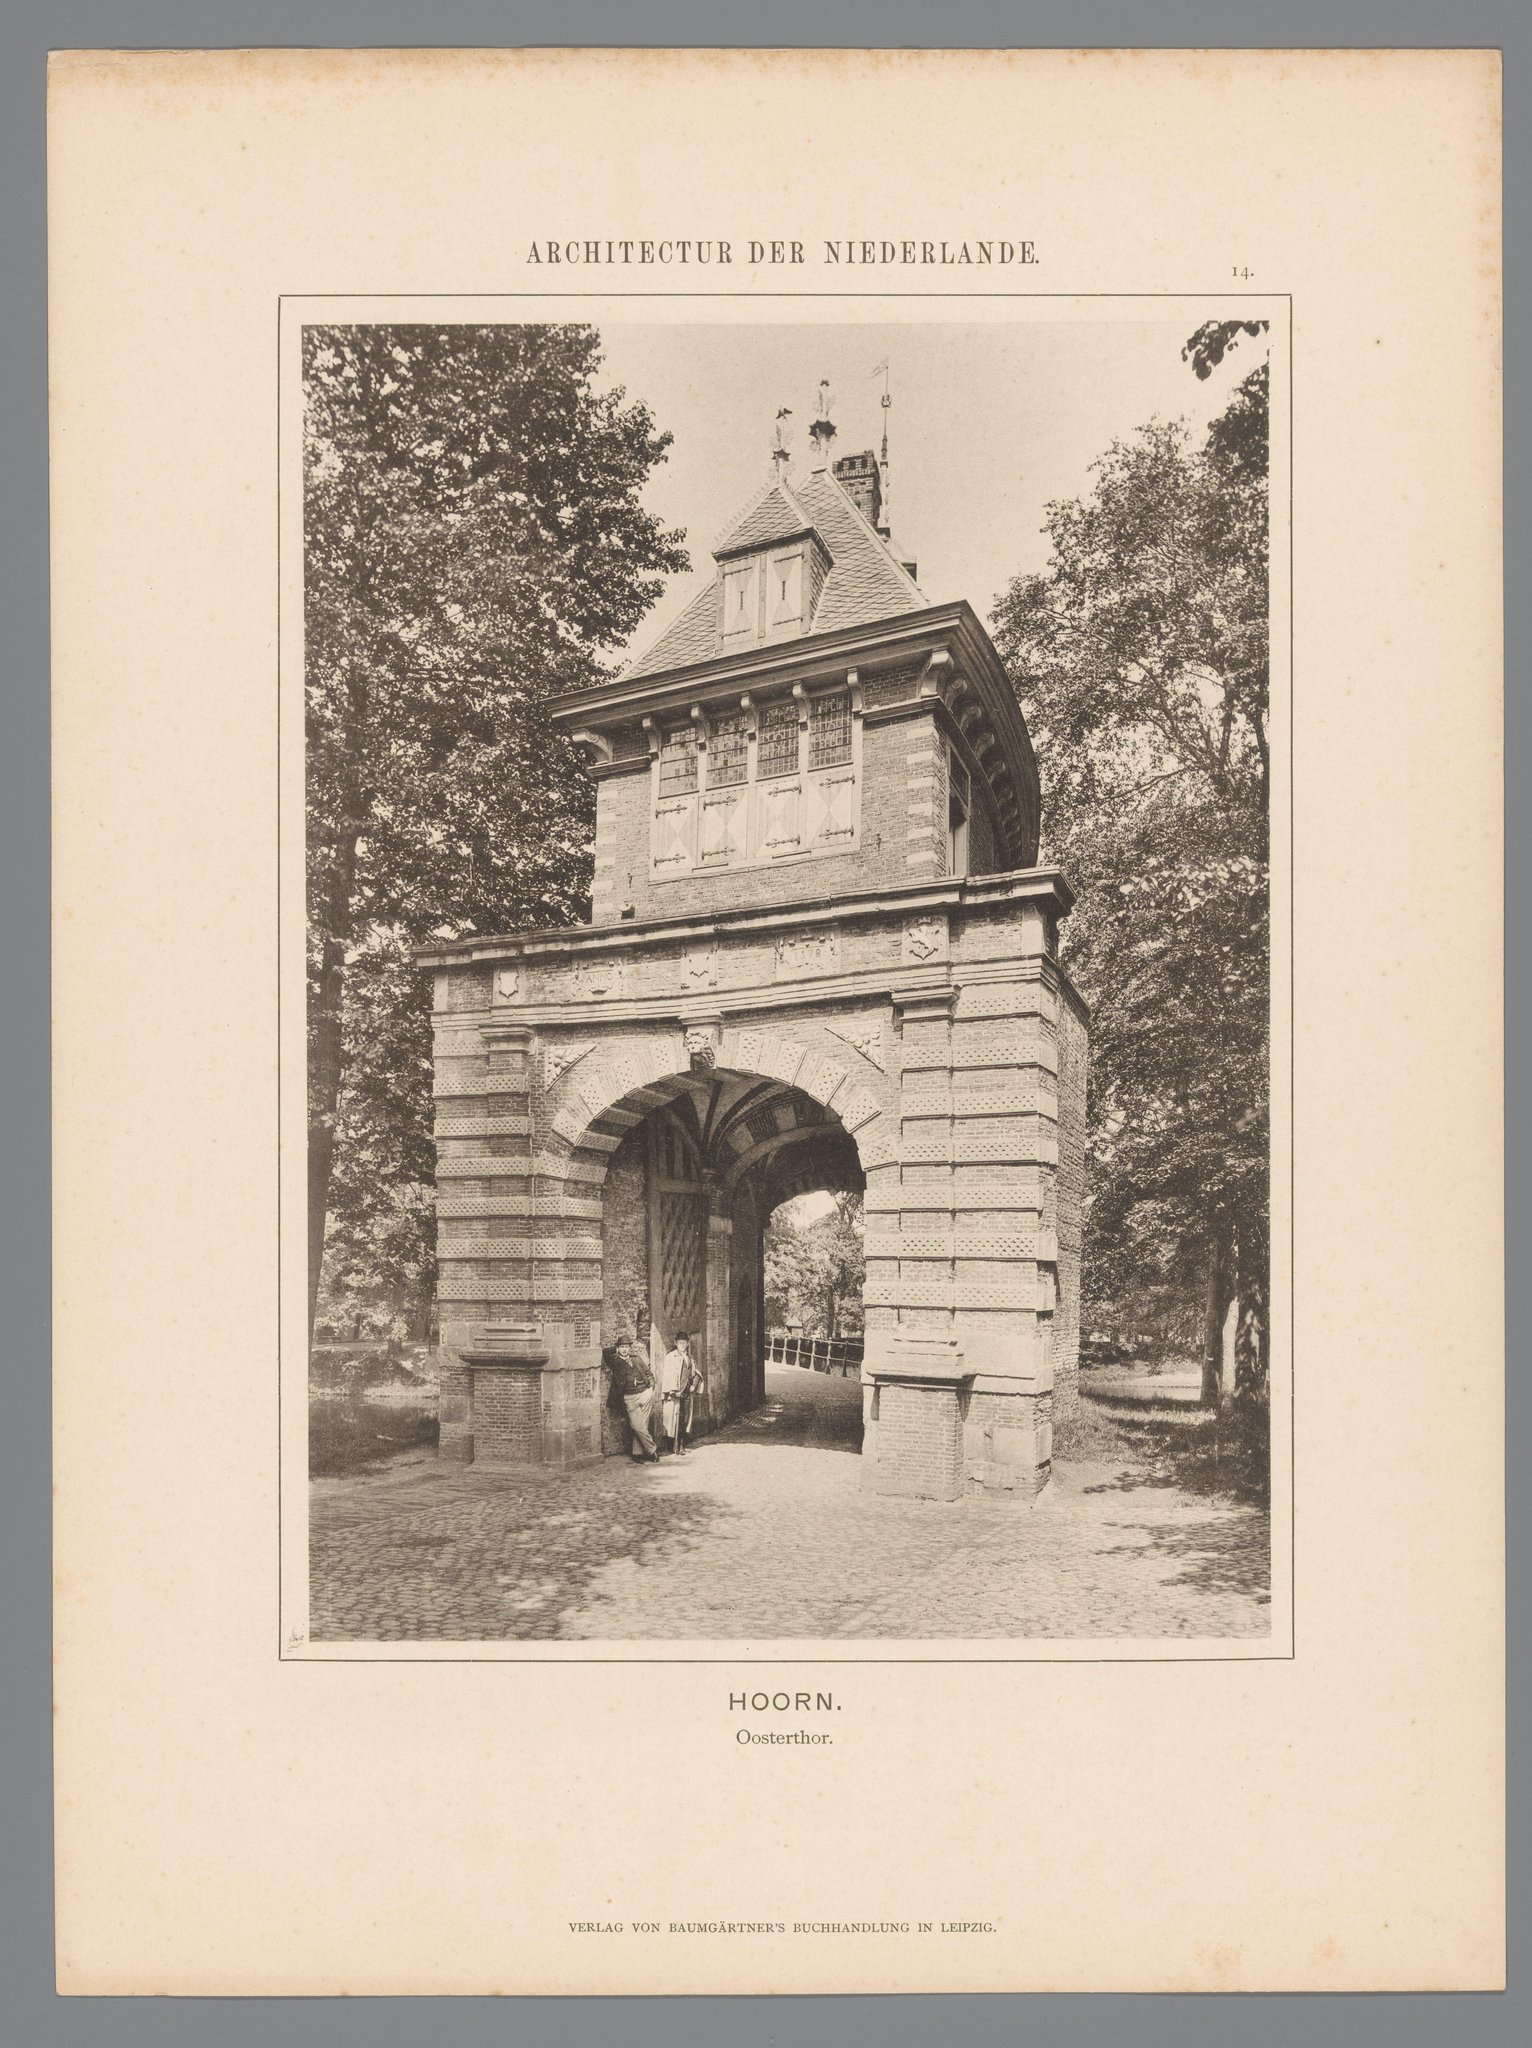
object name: photomechanical print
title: Architectuur in Nederland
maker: Anonymous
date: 1894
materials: paper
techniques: photograph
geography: leipzig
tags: city-gate, hoorn (north holland)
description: Afdruk uit: Krook, L. Architectur der Niederlande. Leipzig: Baumgärtner's Buchhandlung, 1894.